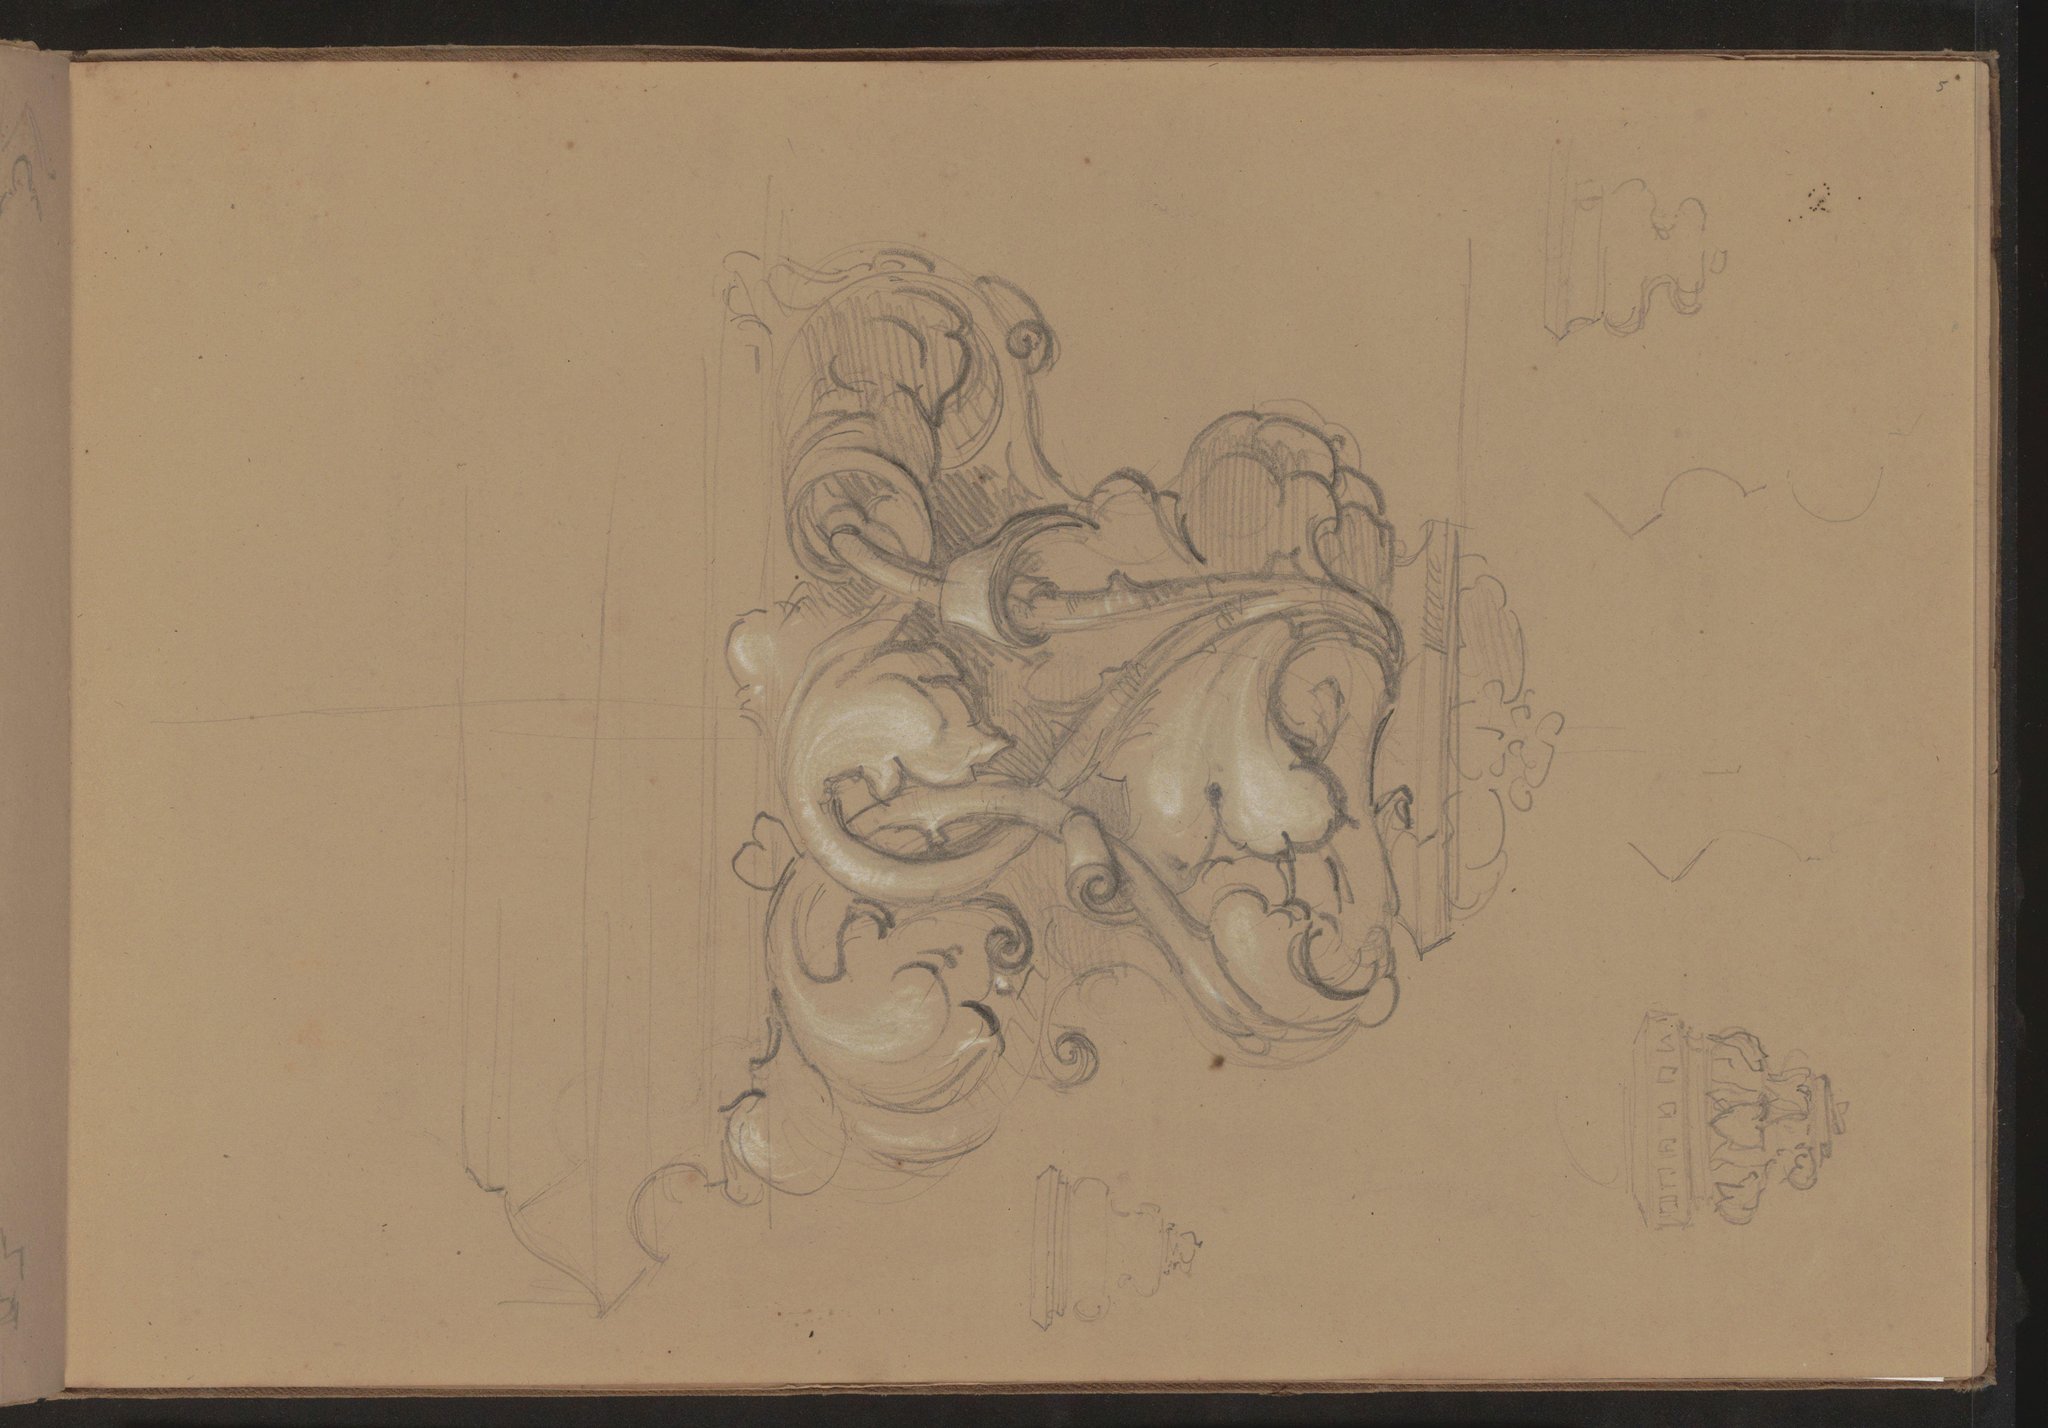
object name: sketchbook leaf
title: Kapiteel met bladmotief en rolwerk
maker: pierre joseph hubert cuypers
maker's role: draughtsman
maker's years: 1827-1921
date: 1837-1921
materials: chalk, paper, pencil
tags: ribbon, scroll, banderole ~ ornament, capital (~ column, pillar), foliage, tendrils, branches ~ ornament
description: Tevens drie studies van kapitelen. Blad 5 recto uit een schetsboek met 23 bladen.